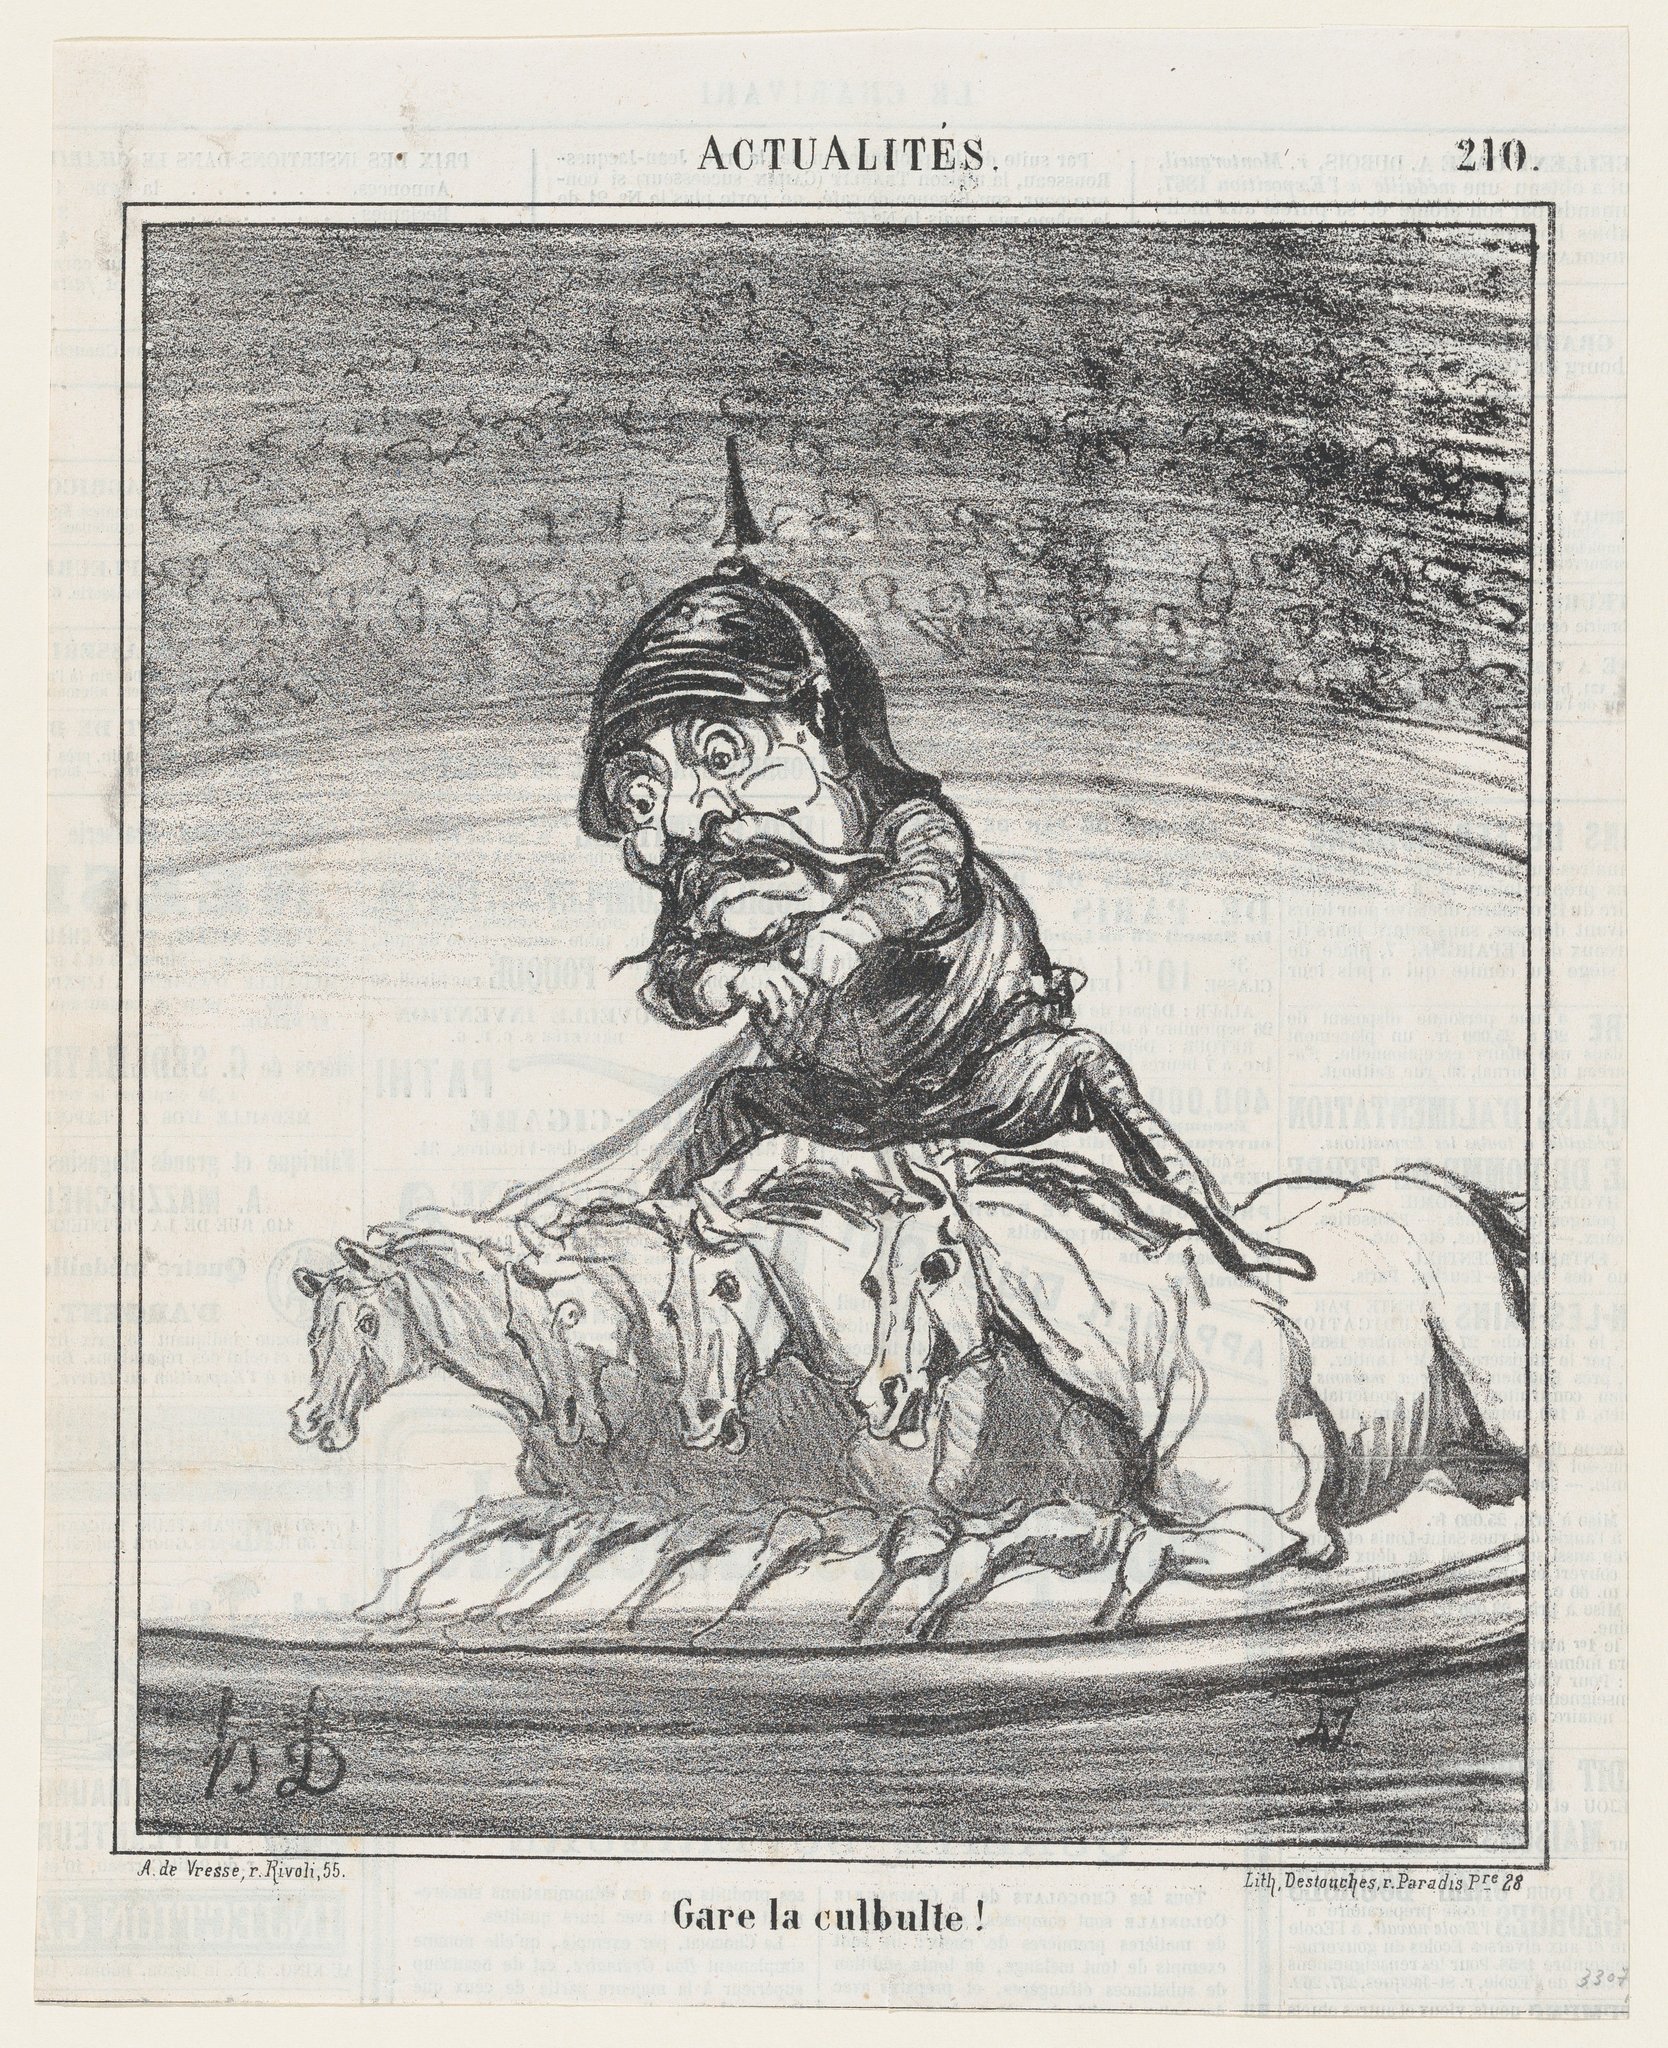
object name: print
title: Don't fall!, from 'News of the day,' published in "Le Charivari"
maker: honoré daumier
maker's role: artist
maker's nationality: french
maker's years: 1808-1879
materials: paper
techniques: lithograph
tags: satire,men,horses